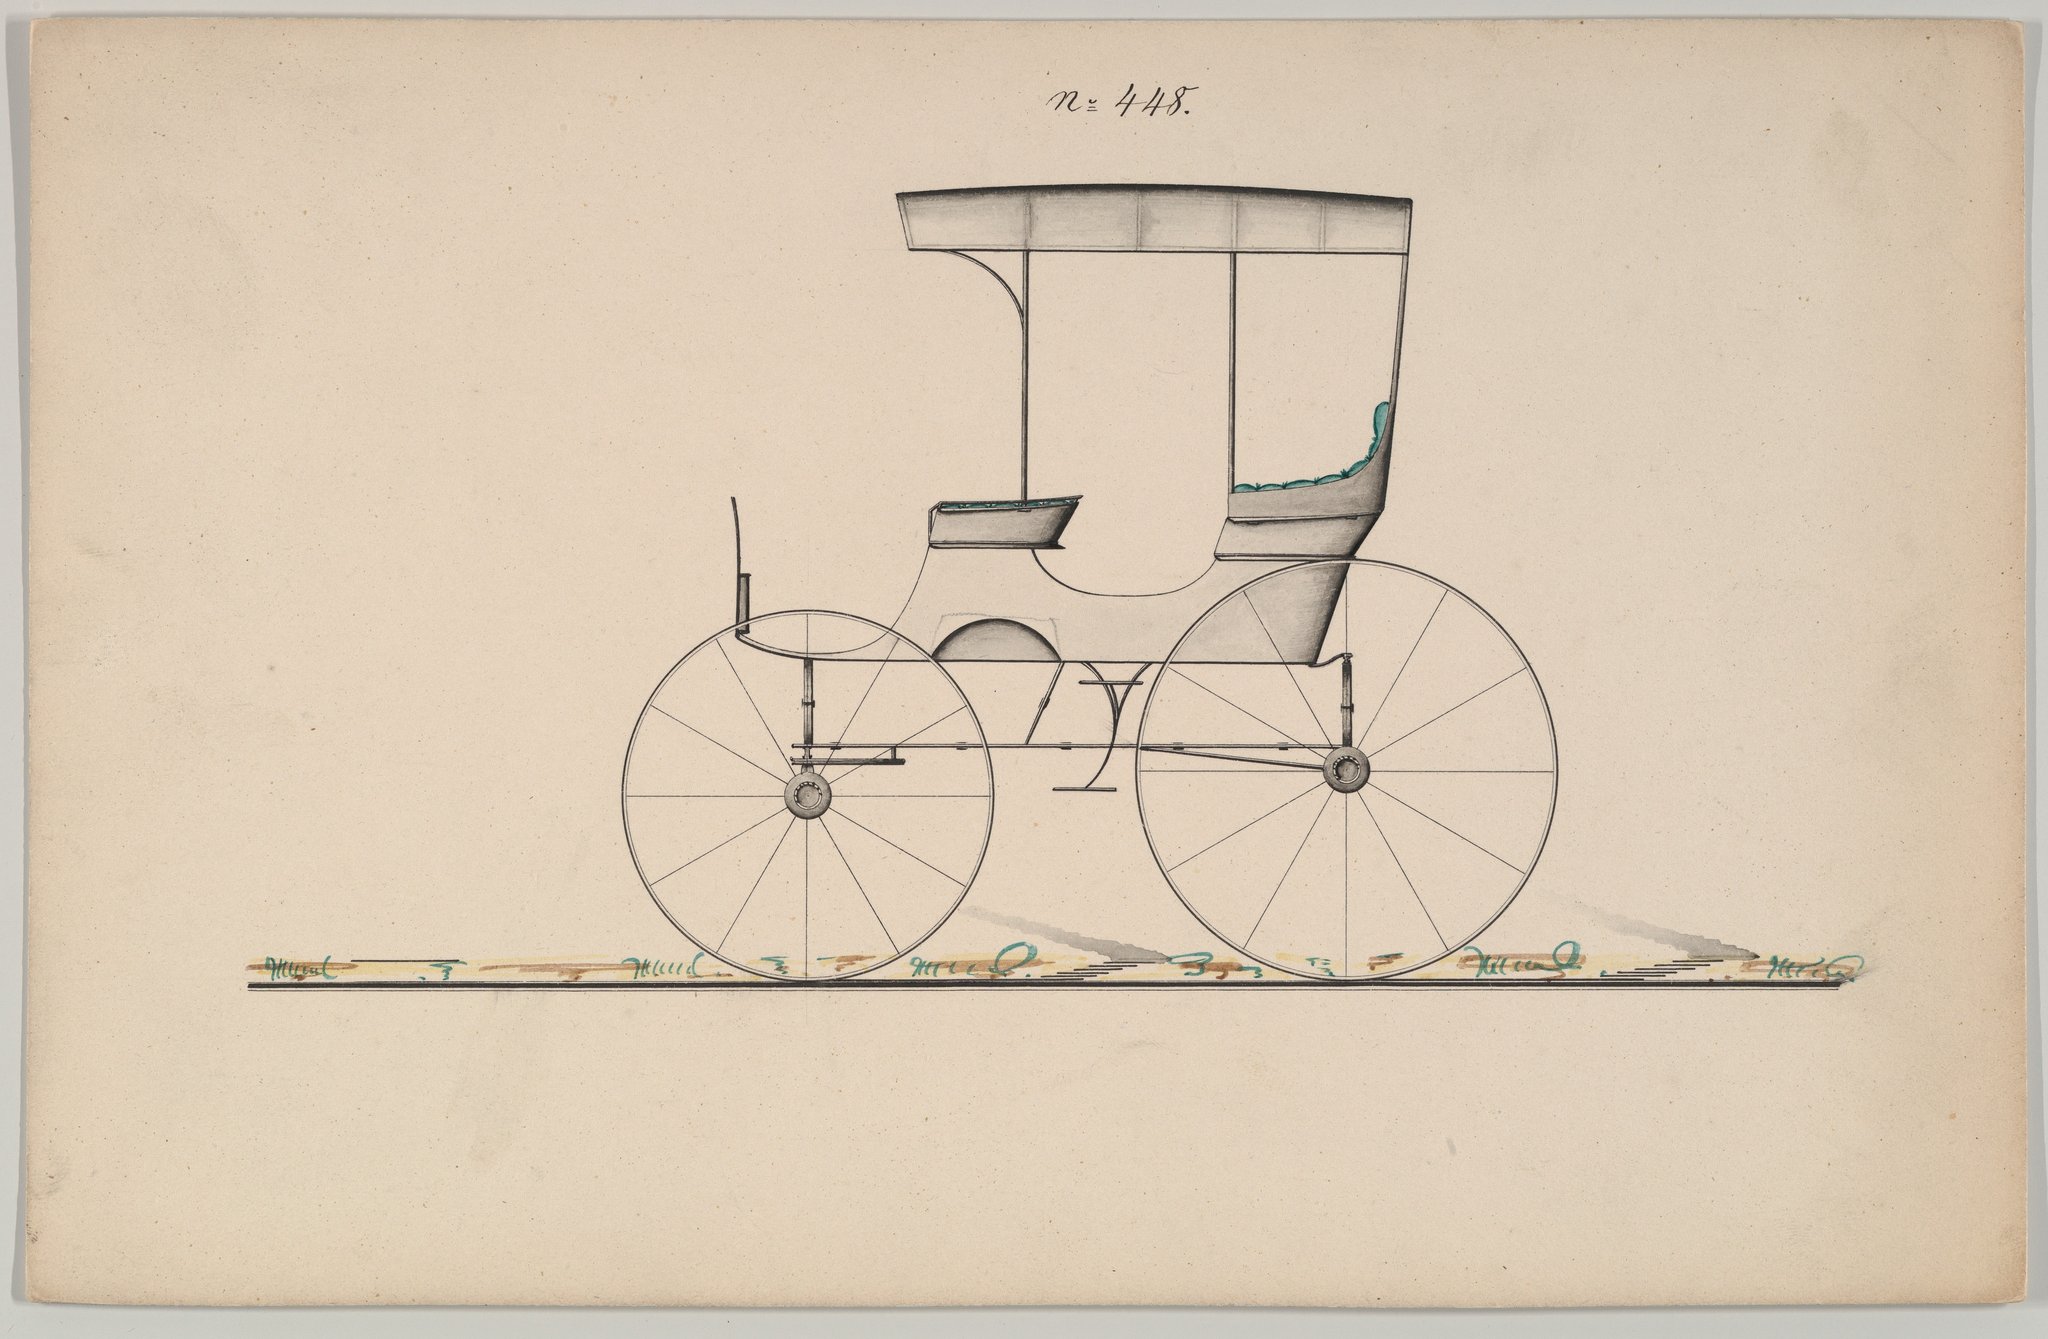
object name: drawing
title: Phaeton # 448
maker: brewster & co.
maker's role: manufacturer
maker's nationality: american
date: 1865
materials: gouache, ink, watercolor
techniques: pen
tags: carriages